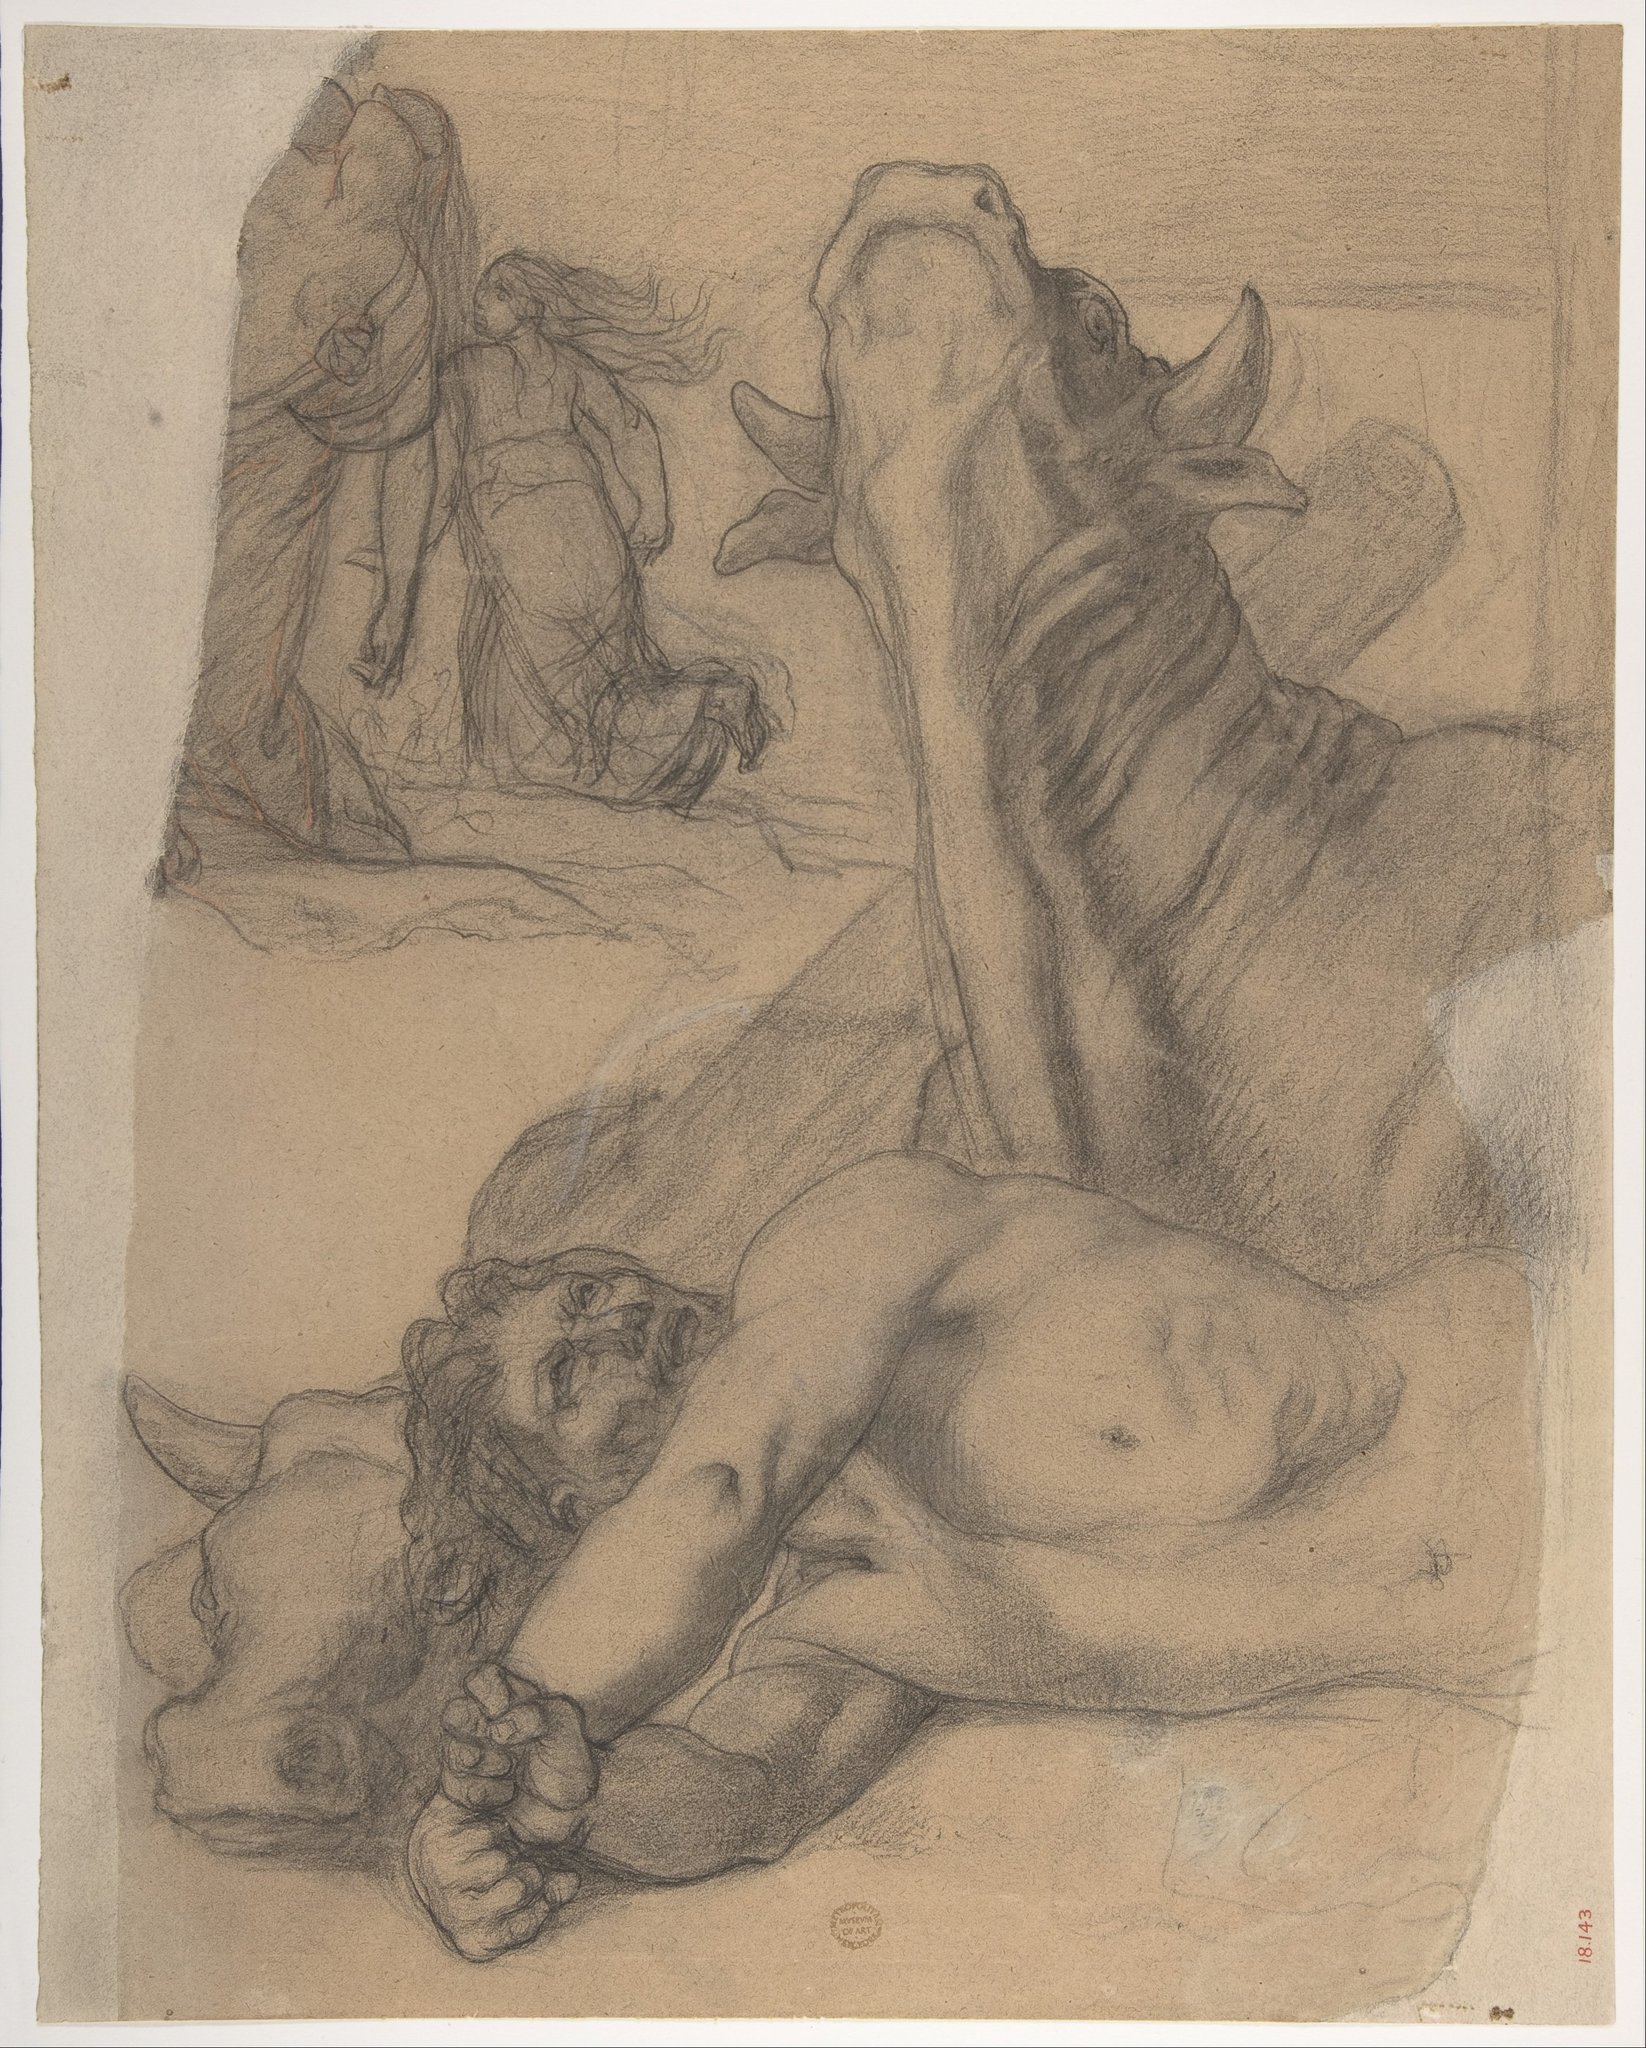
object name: drawing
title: Sketch for War, painting in the Museum of Picardy at Amiens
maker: pierre puvis de chavannes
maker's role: artist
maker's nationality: french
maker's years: 1824-1898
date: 1861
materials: chalk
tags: animals,men,women